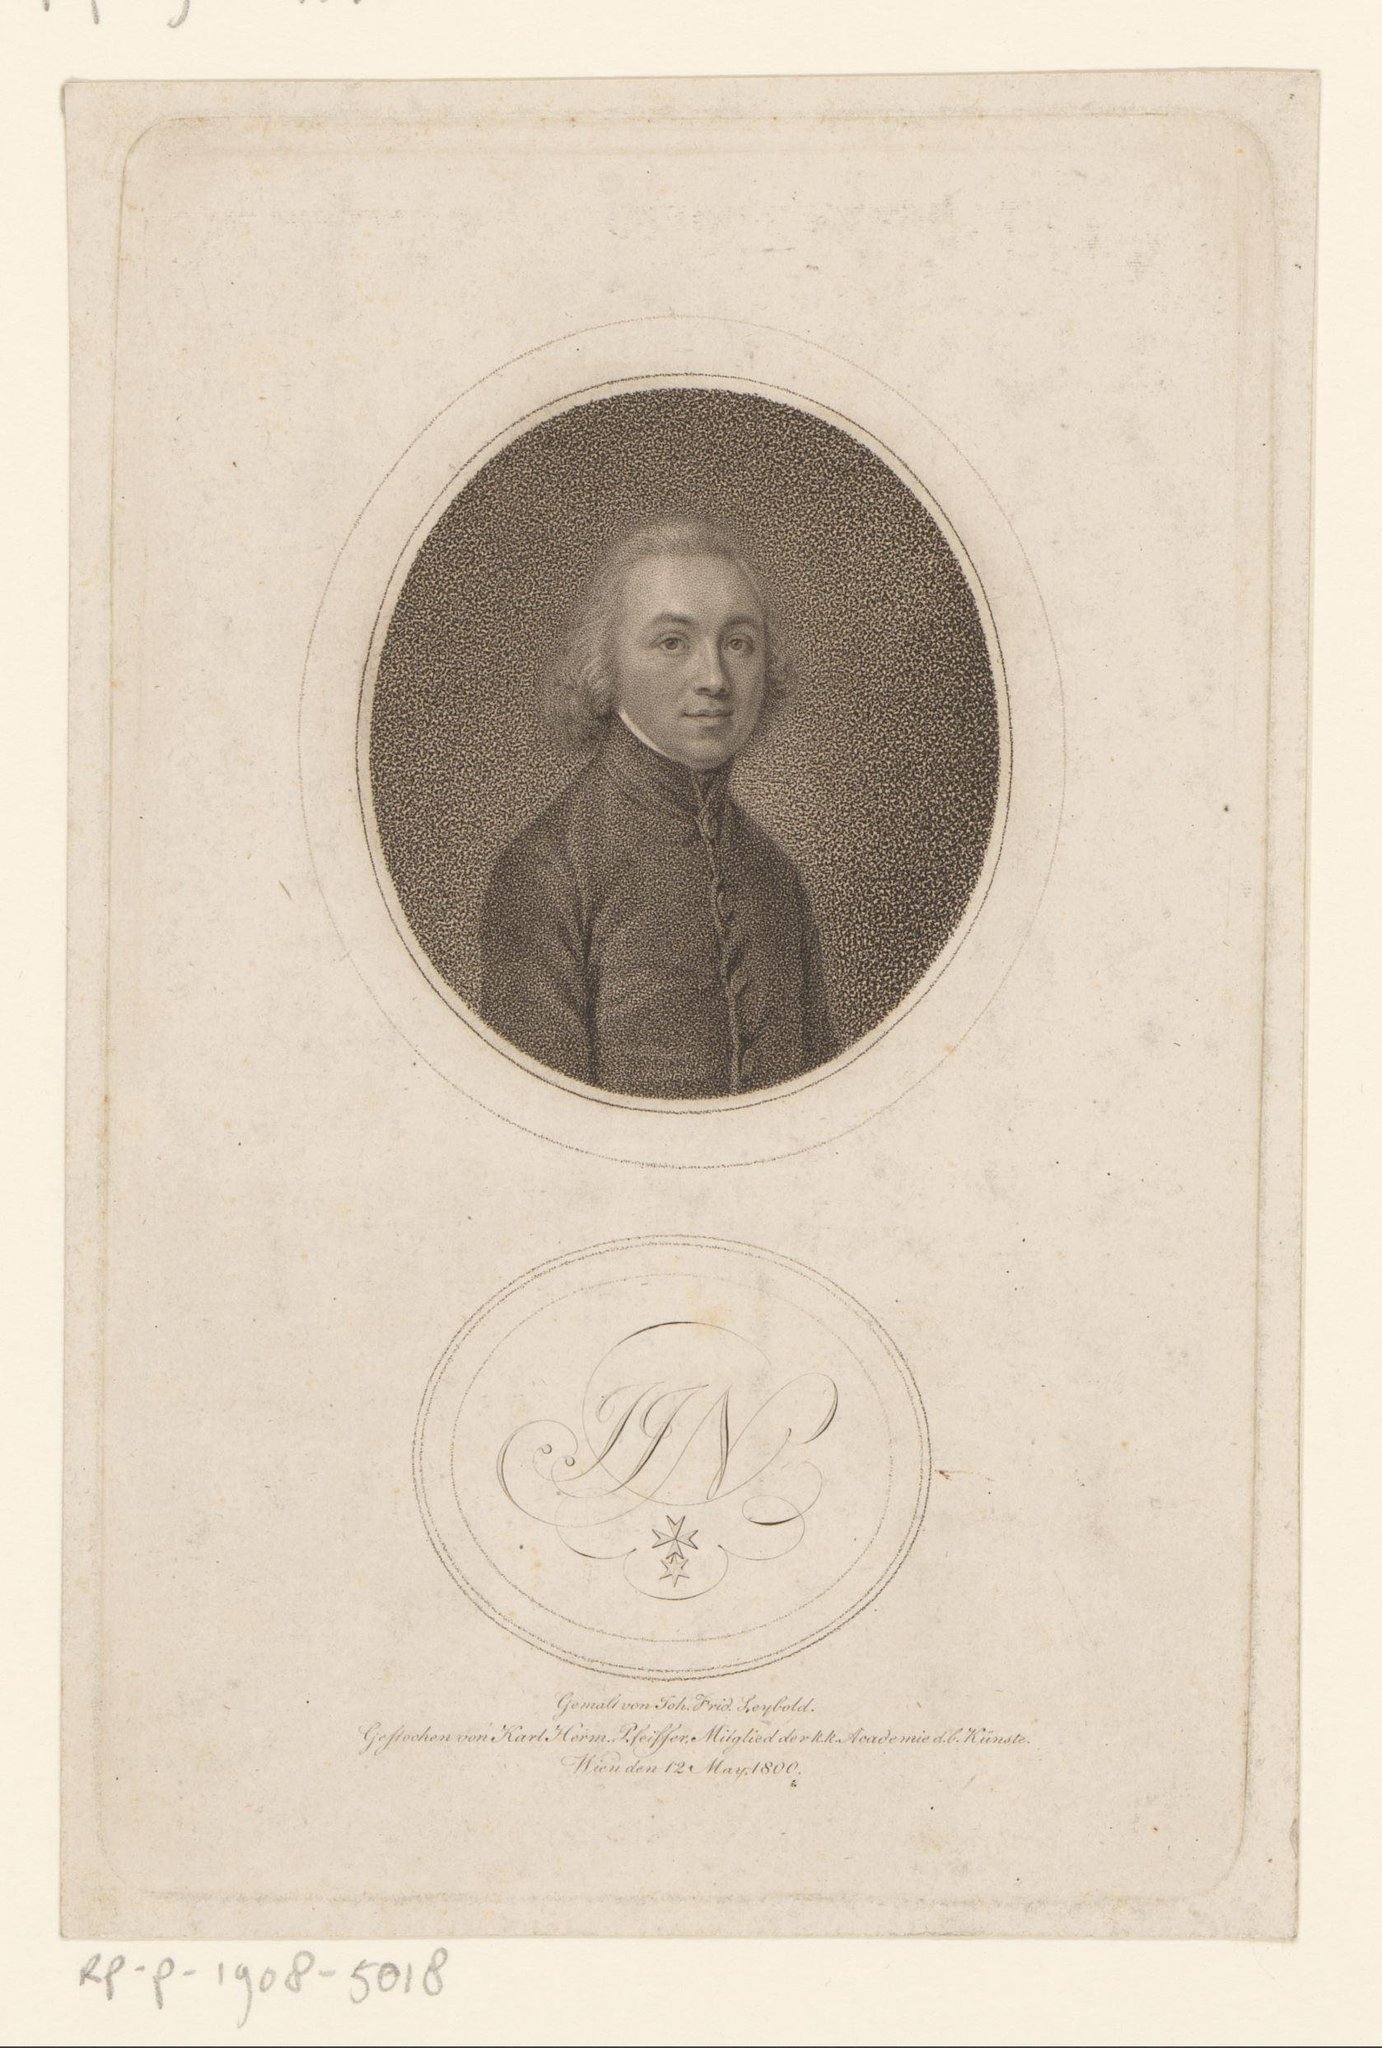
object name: print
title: Portret van Johann Joseph Natter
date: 1800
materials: paper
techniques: stippled etching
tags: historical persons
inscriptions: collector's mark: Lugt 2228